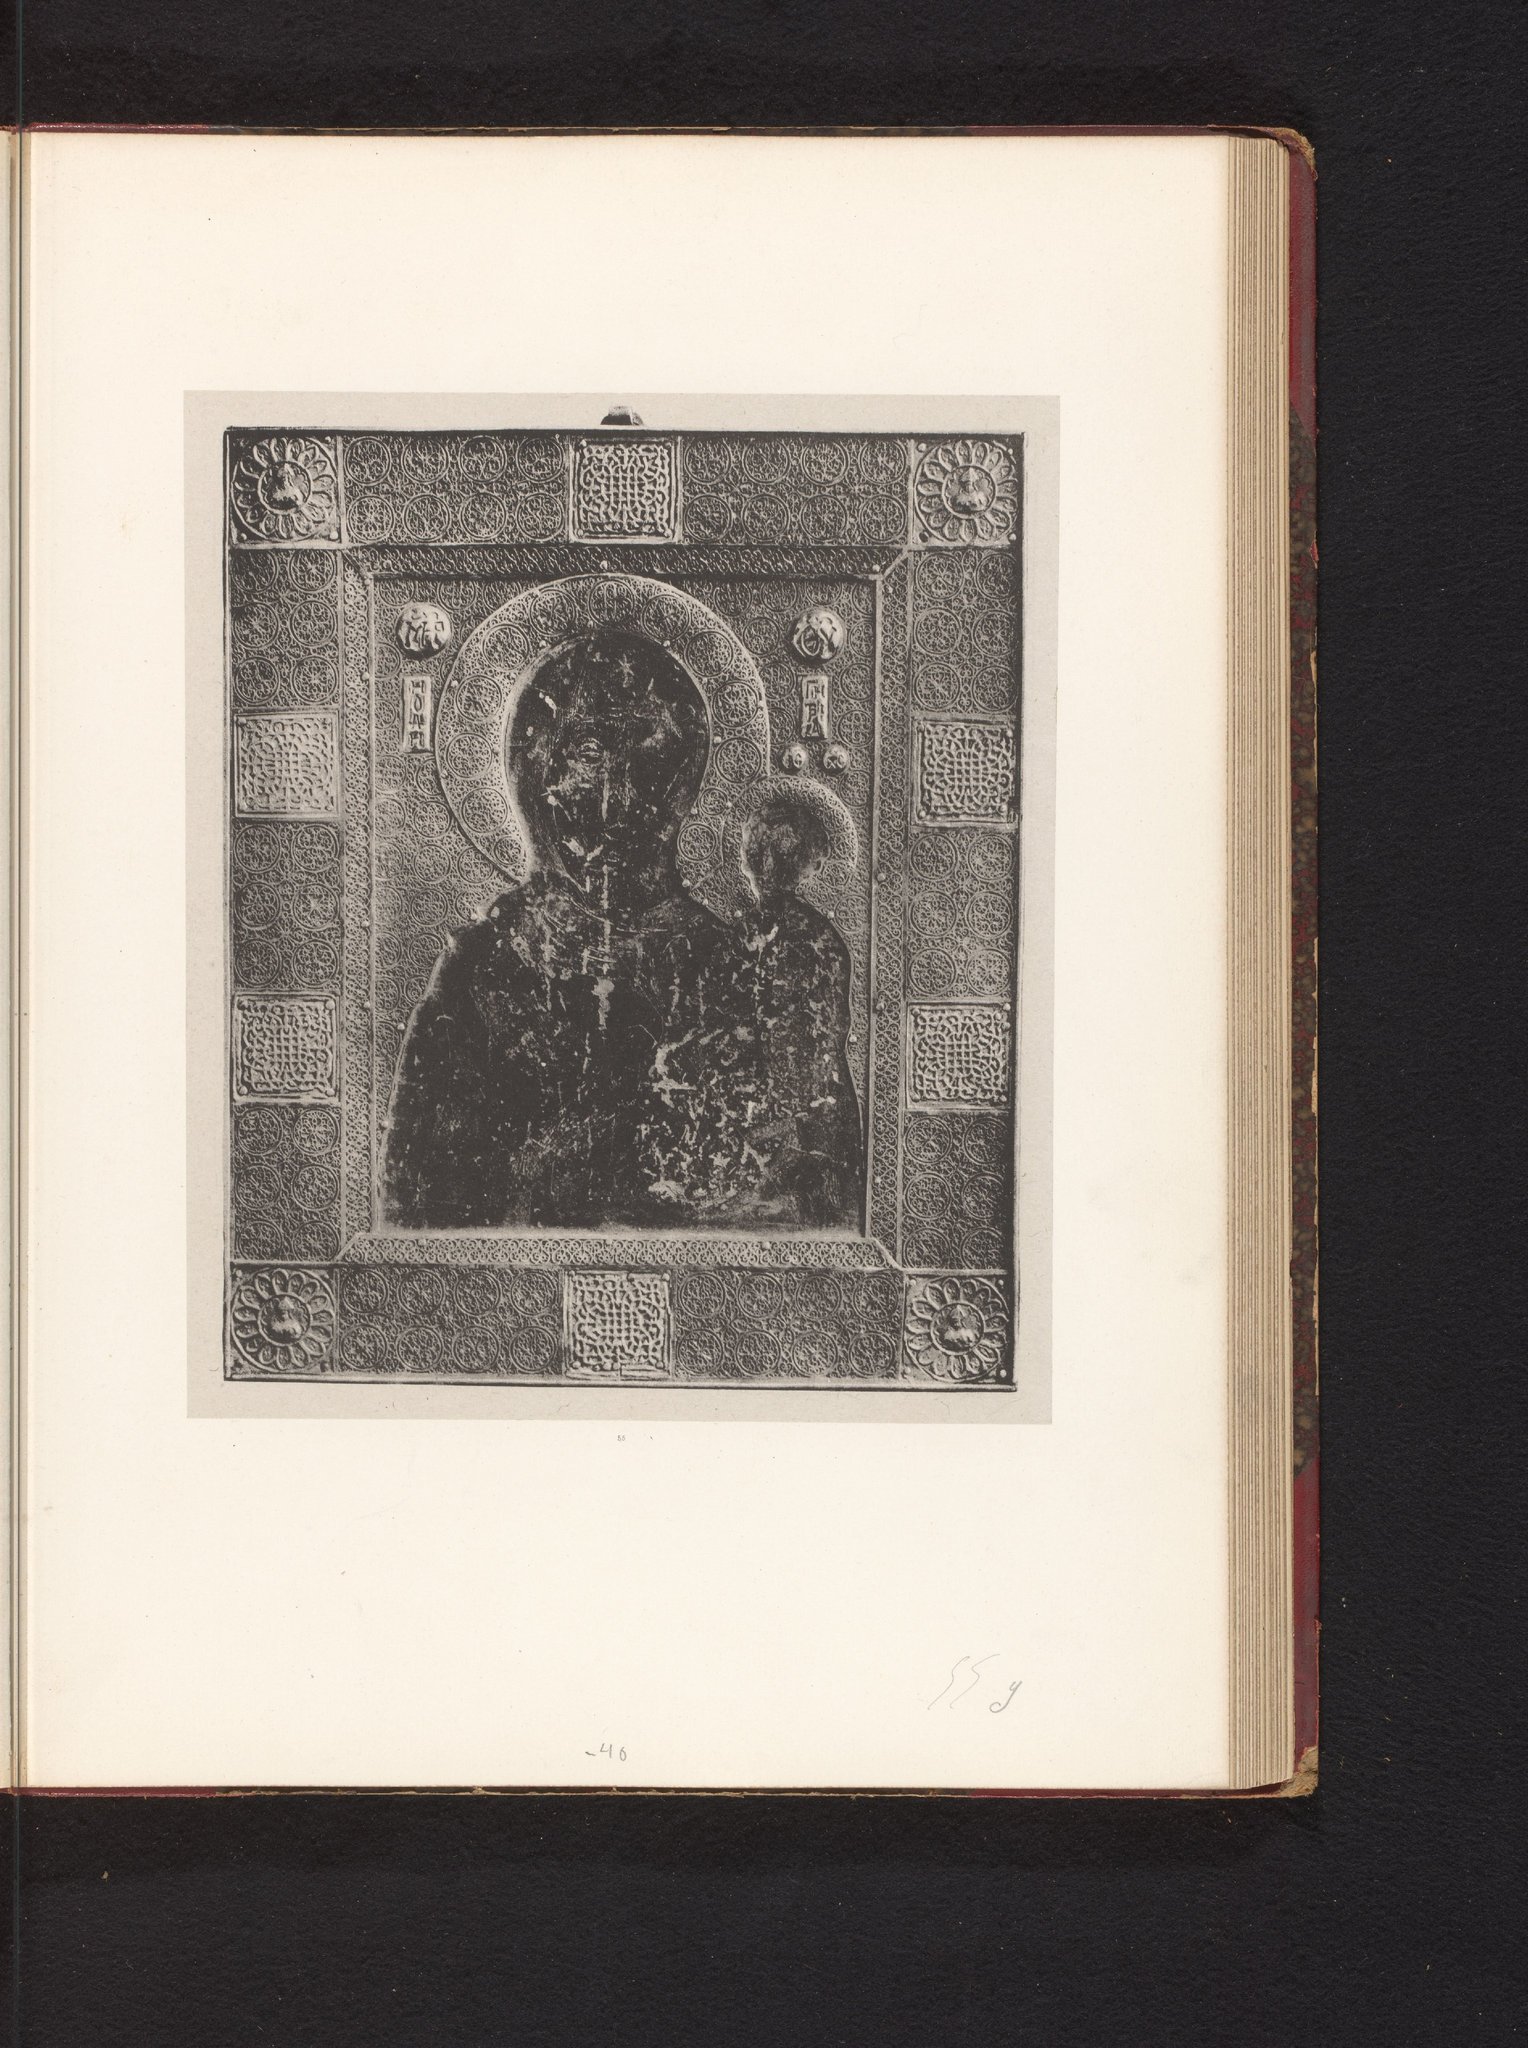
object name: photomechanical print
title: Byzantijns reliëf van Maria met kind uit de Sint-Pauluskathedraal in Luik, opgesteld op een tentoonstelling over religieuze objecten uit de middeleeuwen en renaissance in 1864 in Mechelen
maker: joseph maes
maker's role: fotograaf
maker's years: 1838-1908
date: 1864-1866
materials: paper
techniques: photolithography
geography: mechelen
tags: piece of sculpture, reproduction of a piece of sculpture (+ byzantine art), mary standing (or half-length), the christ-child in front of her, close to her bosom, mechelen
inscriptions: number: ‘-40’, number: ‘55 y’, number: ‘55’